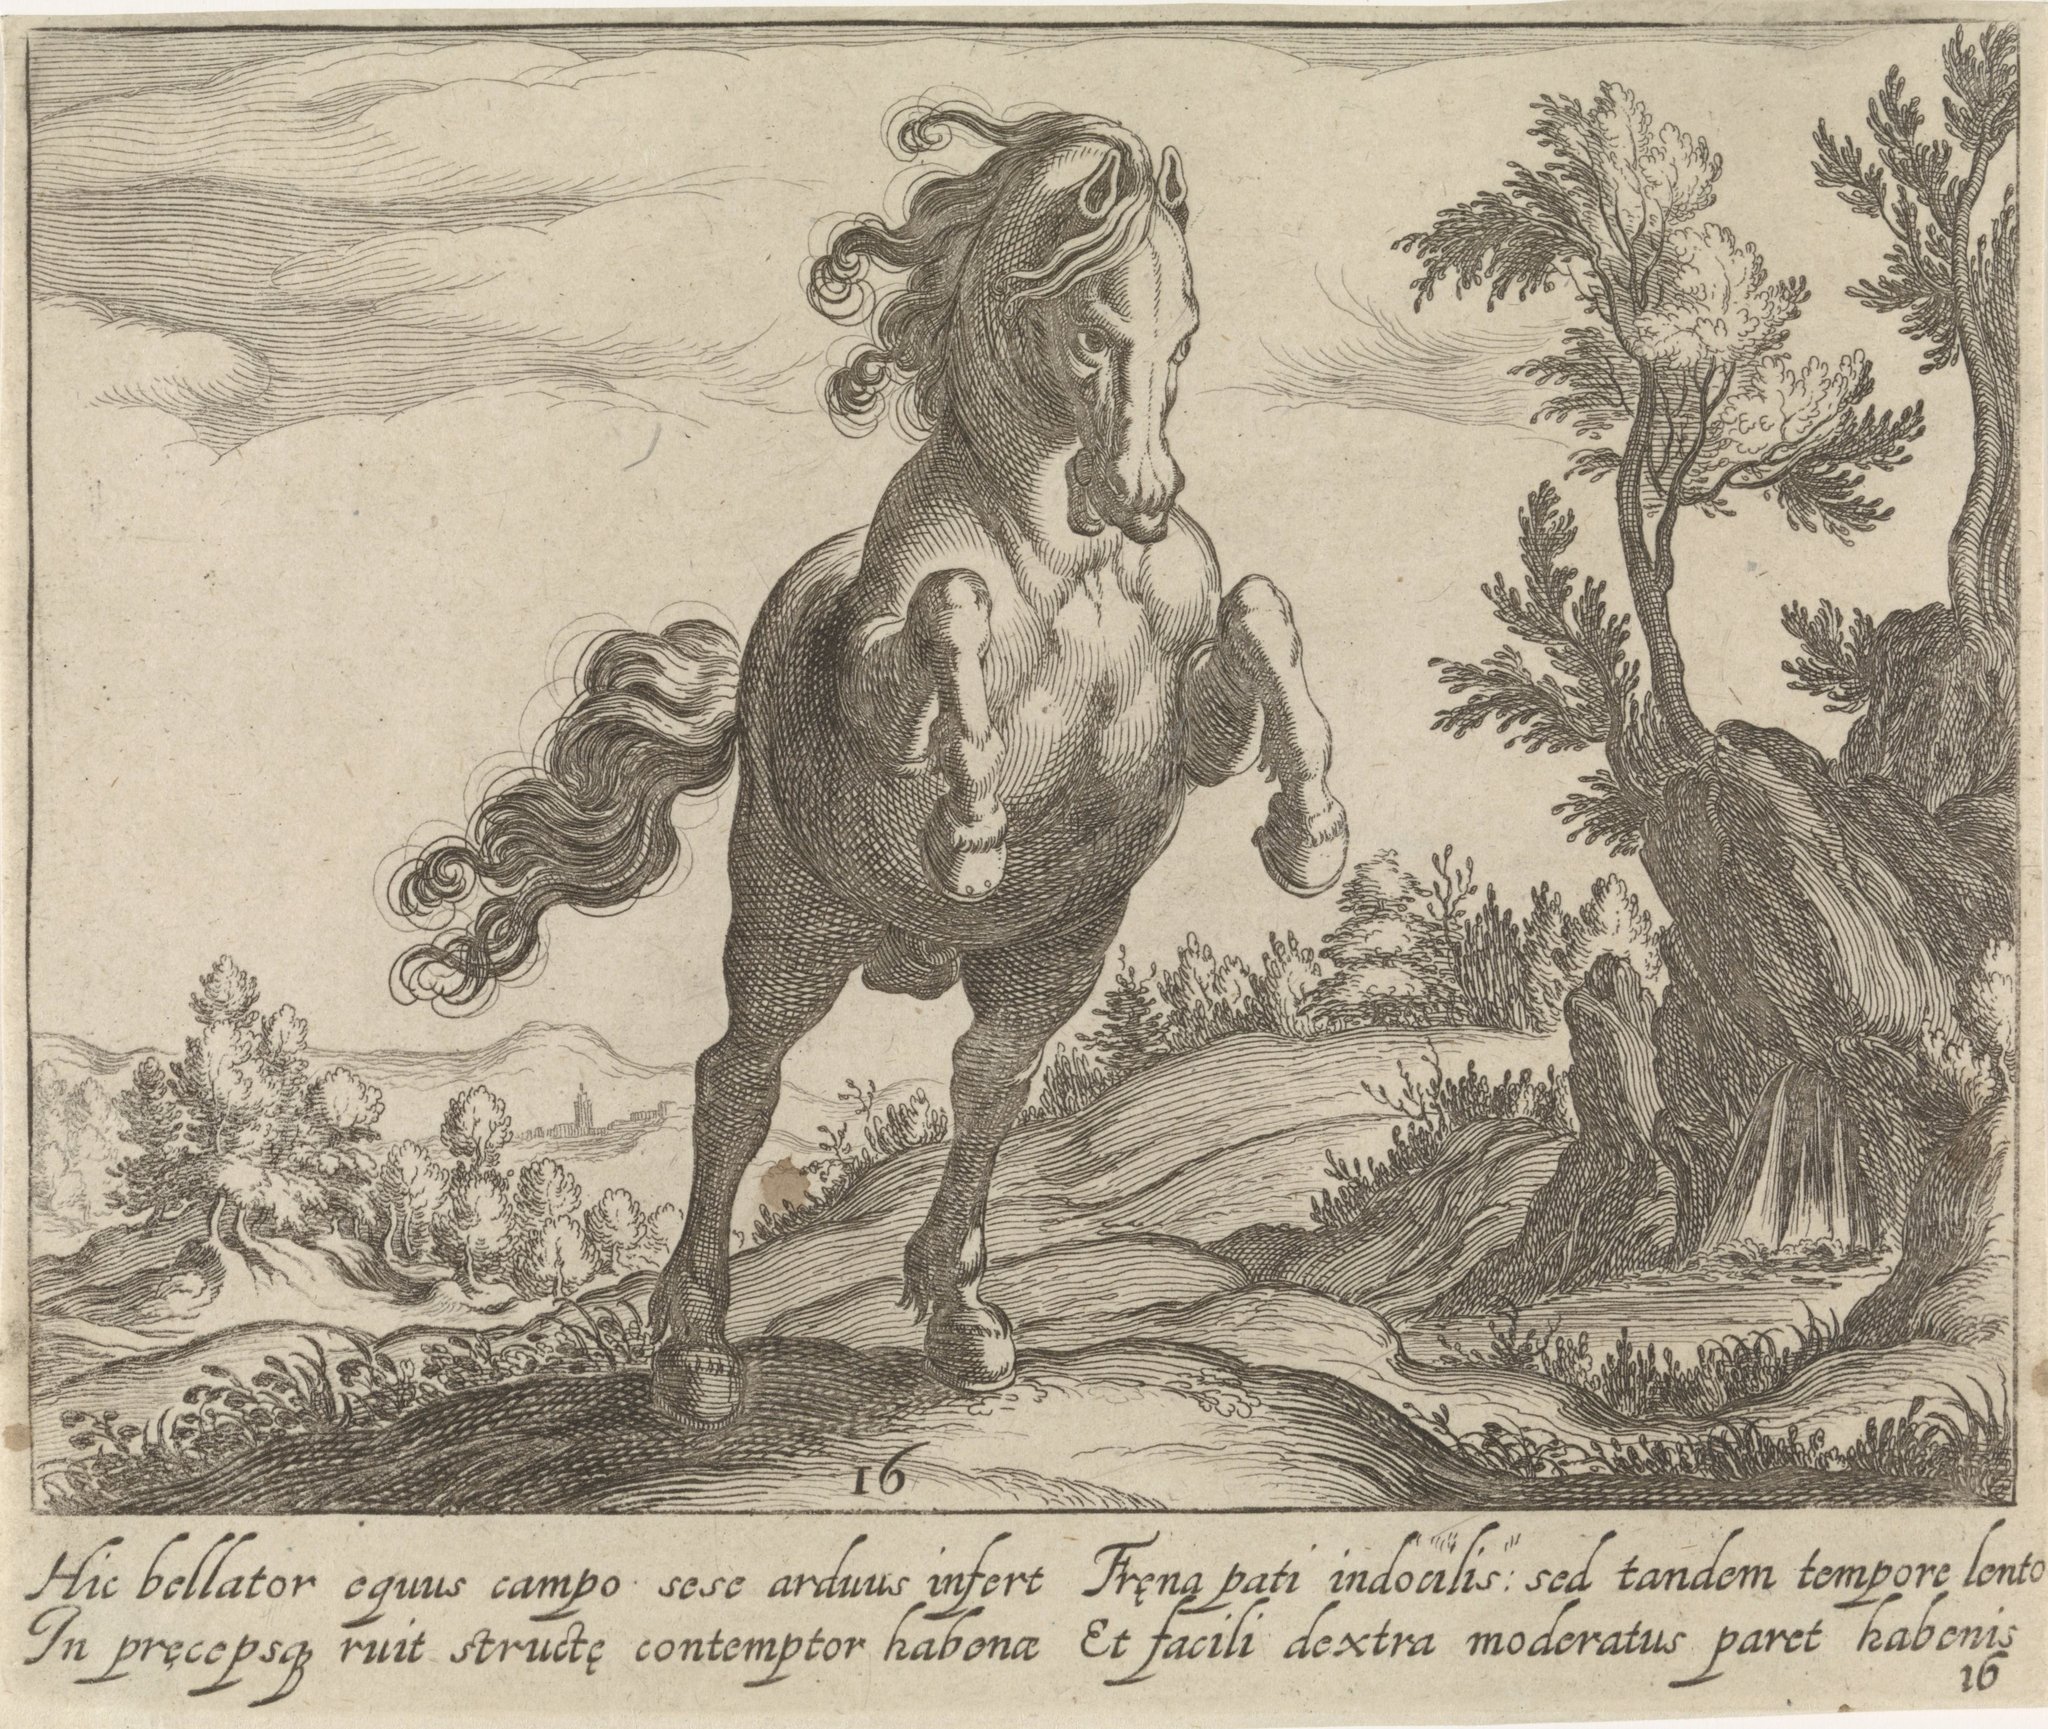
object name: print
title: Landschap met steigerend paard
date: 1590-1637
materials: paper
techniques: engraving, etching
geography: amsterdam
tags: horse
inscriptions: collector's mark: Lugt 2228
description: Heuvelachtig landschap met steigerend paard, van voren. In de marge een tweeregelig onderschrift in het Latijn. Prent uit een serie van dertig met paardenrassen.